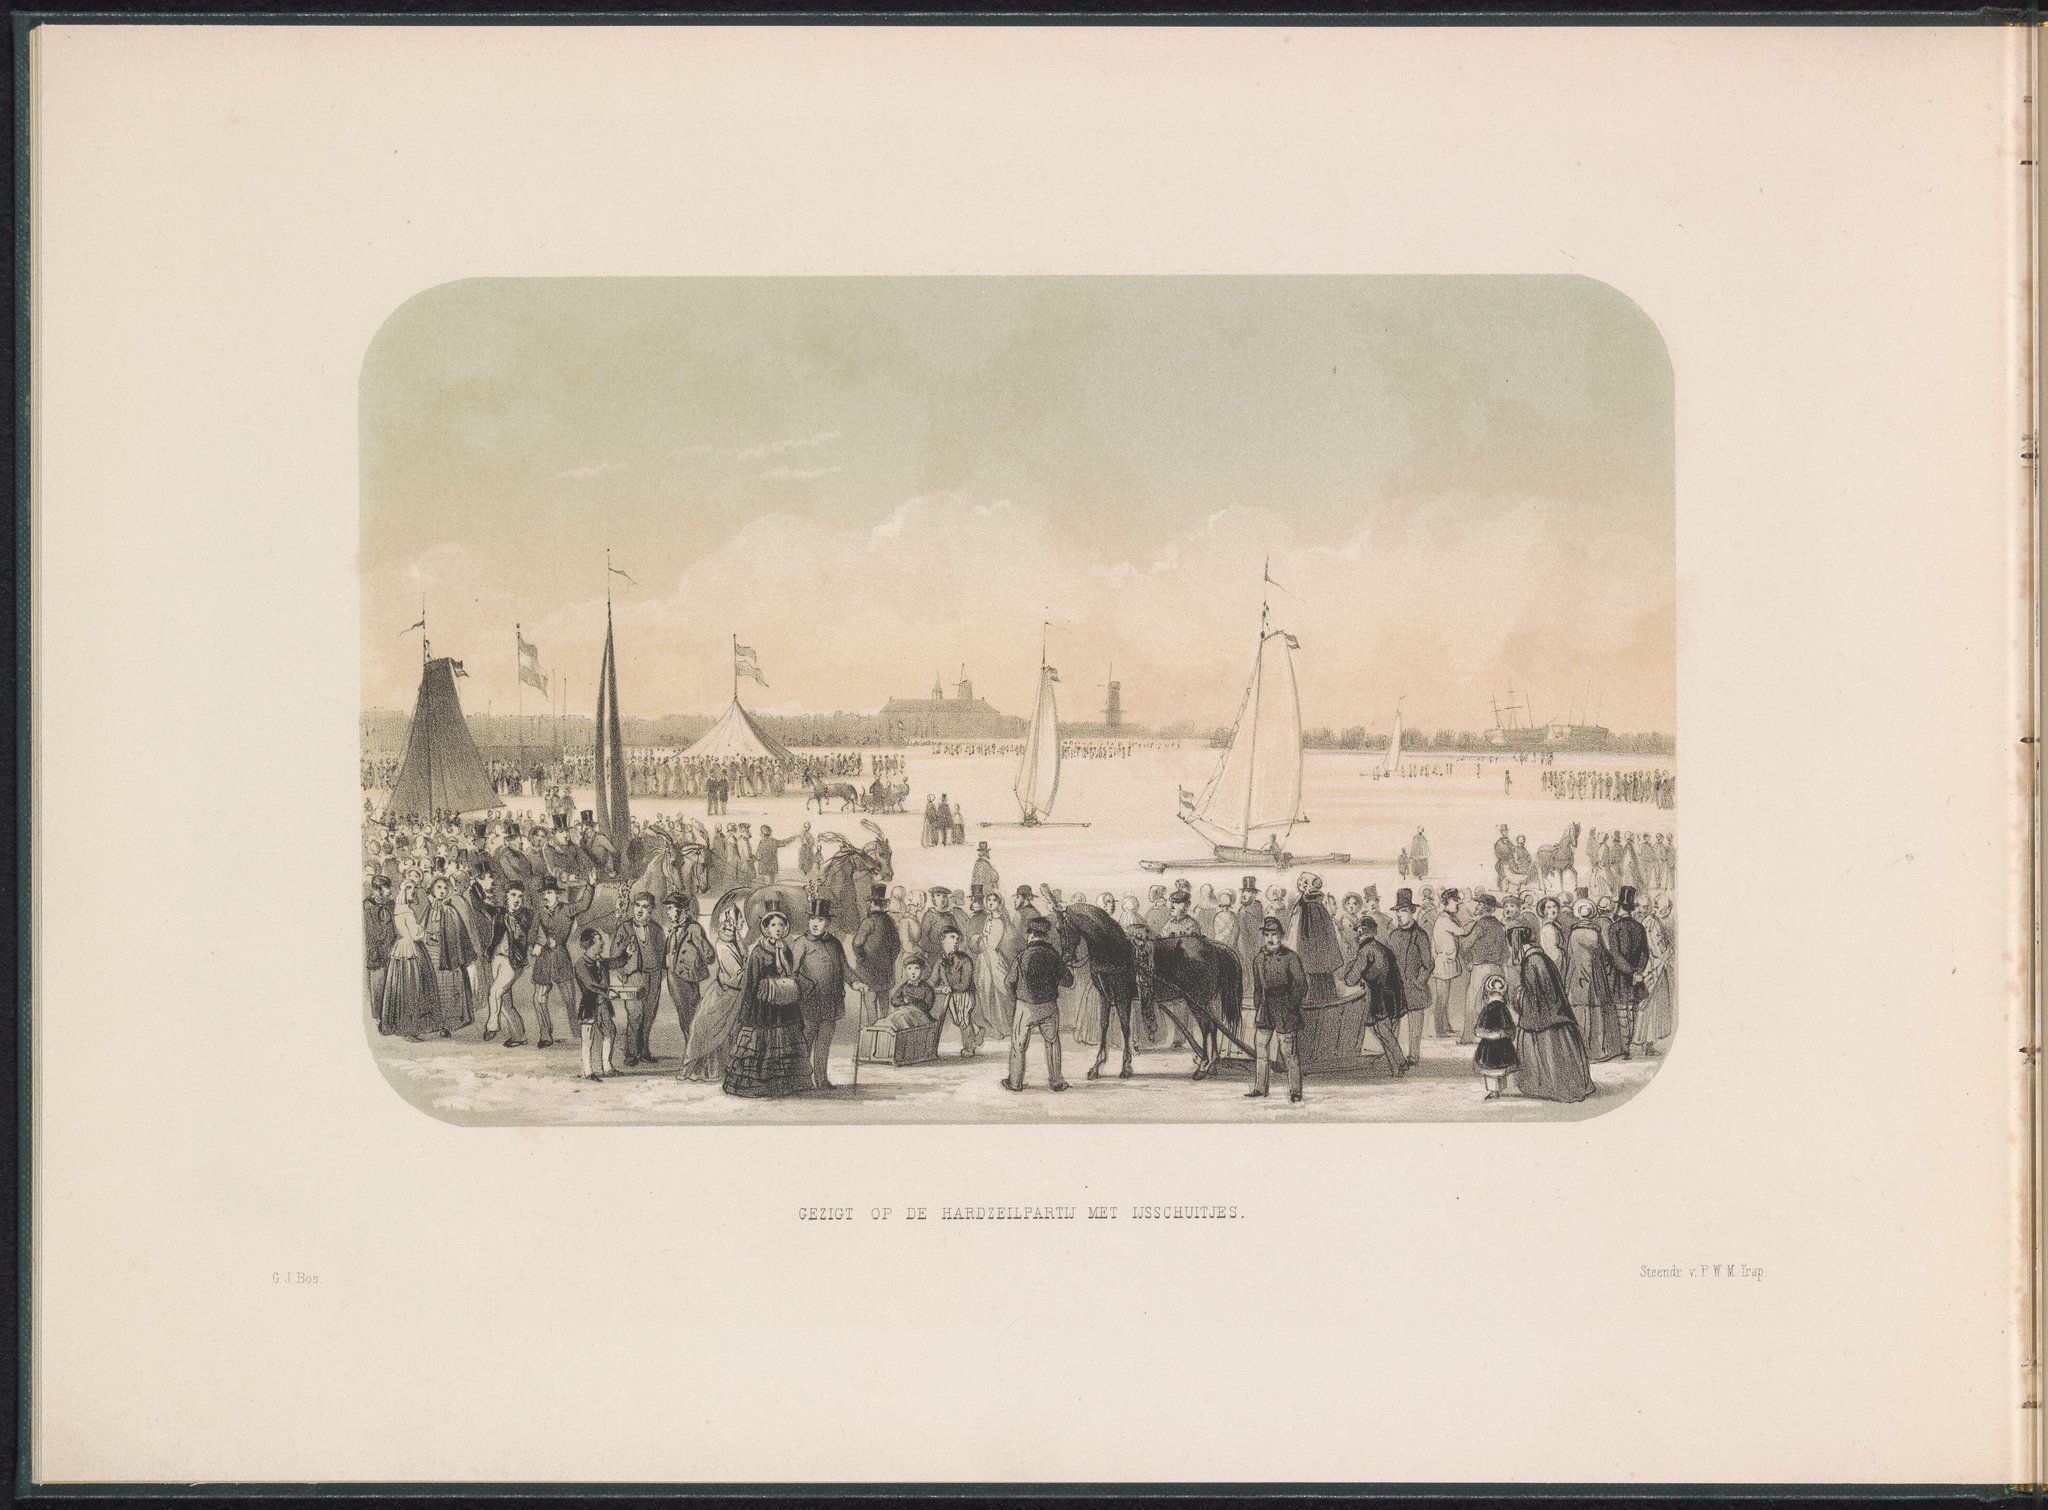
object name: print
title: Gezigt op de hardzeilpartij met ijsschuitjes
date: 1855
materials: paper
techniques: lithograph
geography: leiden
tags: ice-sailing (winter sports), rotterdam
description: Wedstrijd voor ijszeiljachten op de Maas te Rotterdam. Vijfde plaat in een boek met zes platen over het ijsvermaak op de Maas te Rotterdam in februari 1855. Dit exemplaar in 1861 heruitgegeven ten behoeve van de slachtoffers van de watersnood.